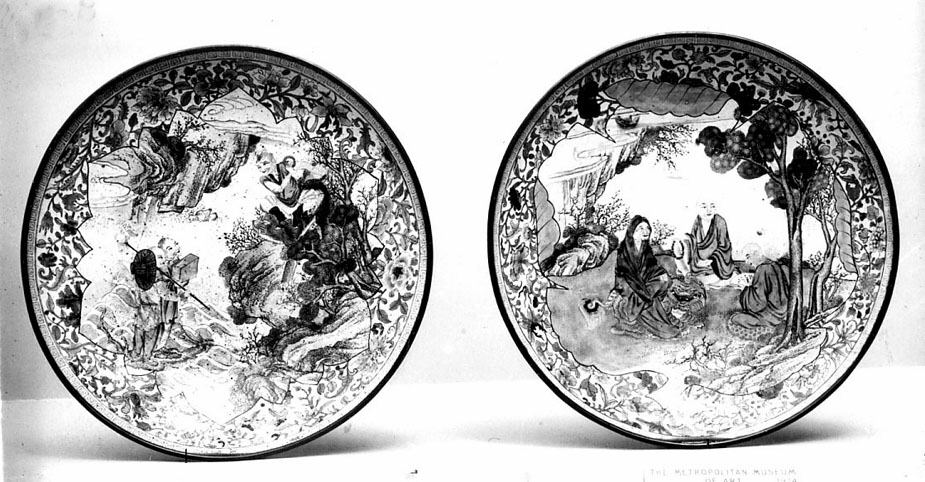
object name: dish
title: Dish (one of a pair)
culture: chinese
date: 1736-1795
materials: enamel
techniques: painting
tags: men,trees